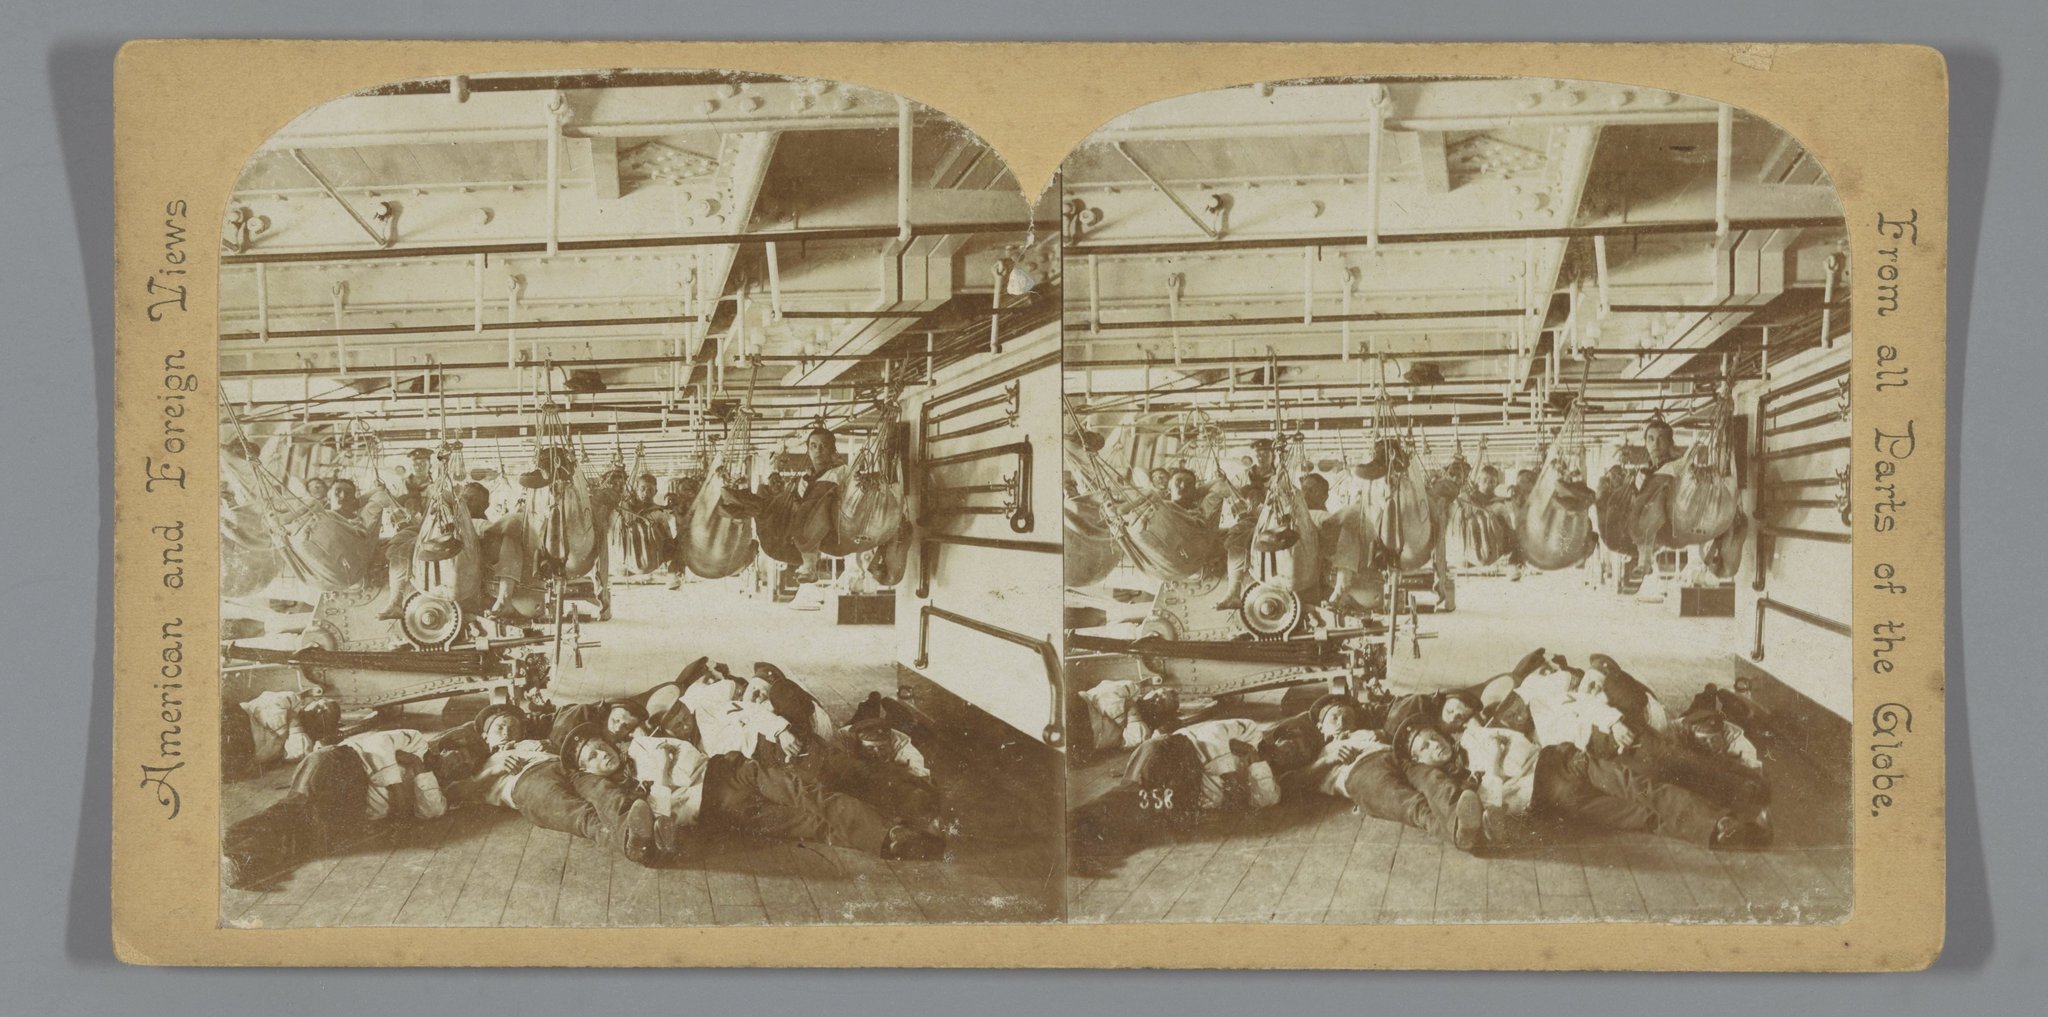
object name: stereograph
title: Matrozen in hangmatten op het tussendek van een schip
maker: Anonymous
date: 1920-1985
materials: cardboard, paper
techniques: albumen print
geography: united states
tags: crew ~ ship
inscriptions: number: ‘062’